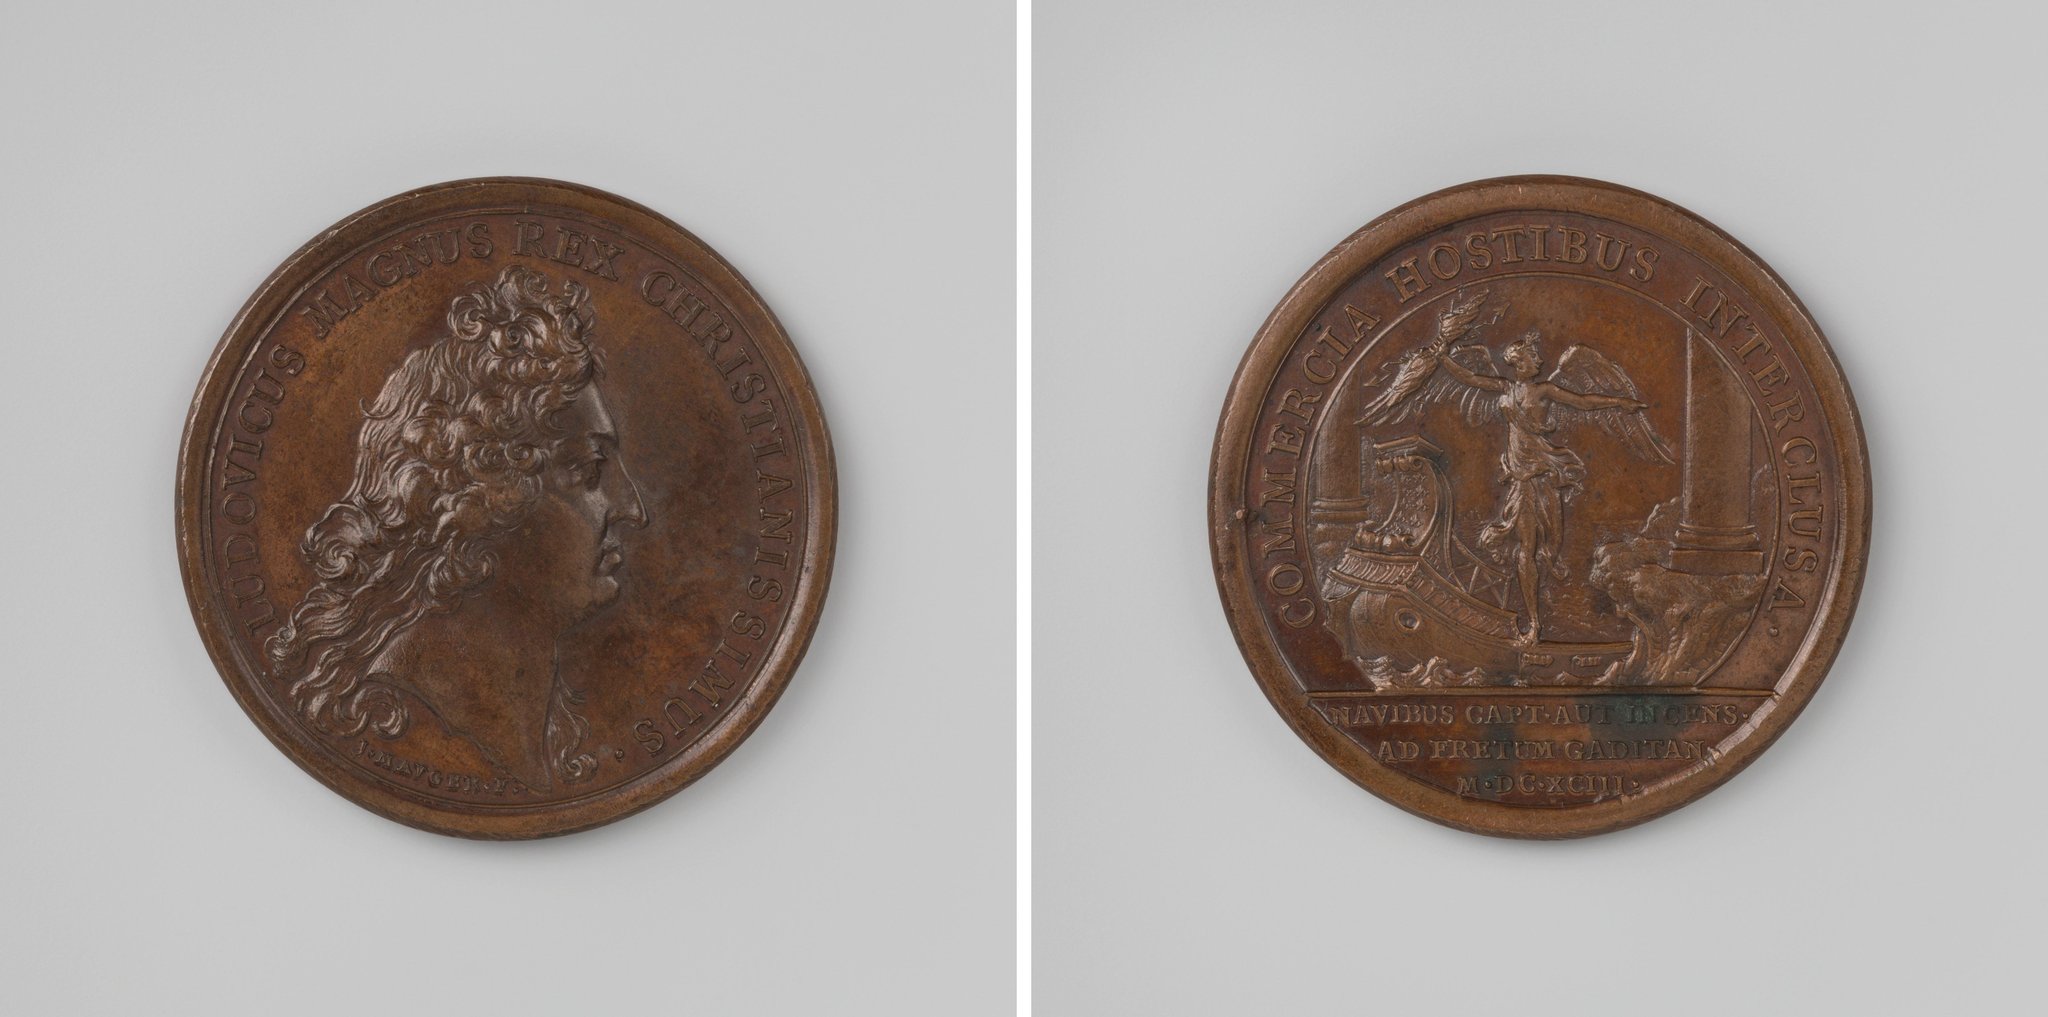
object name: history medal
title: Engelse en Nederlandse schepen door de Fransen genomen of verbrand in de zeeslag bij Gibraltar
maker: jean mauger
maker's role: medailleur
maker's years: 1648-1722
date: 1699-1703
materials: bronze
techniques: striking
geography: paris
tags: lodewijk xiv (koning van frankrijk), great britain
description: Bronzen penning. Voorzijde: borststuk man binnen omschrift. Keerzijde: Overwinning met donder staande op antiek schip tussen zuilen van Hercules binnen omschrift; afsnede: opschrift